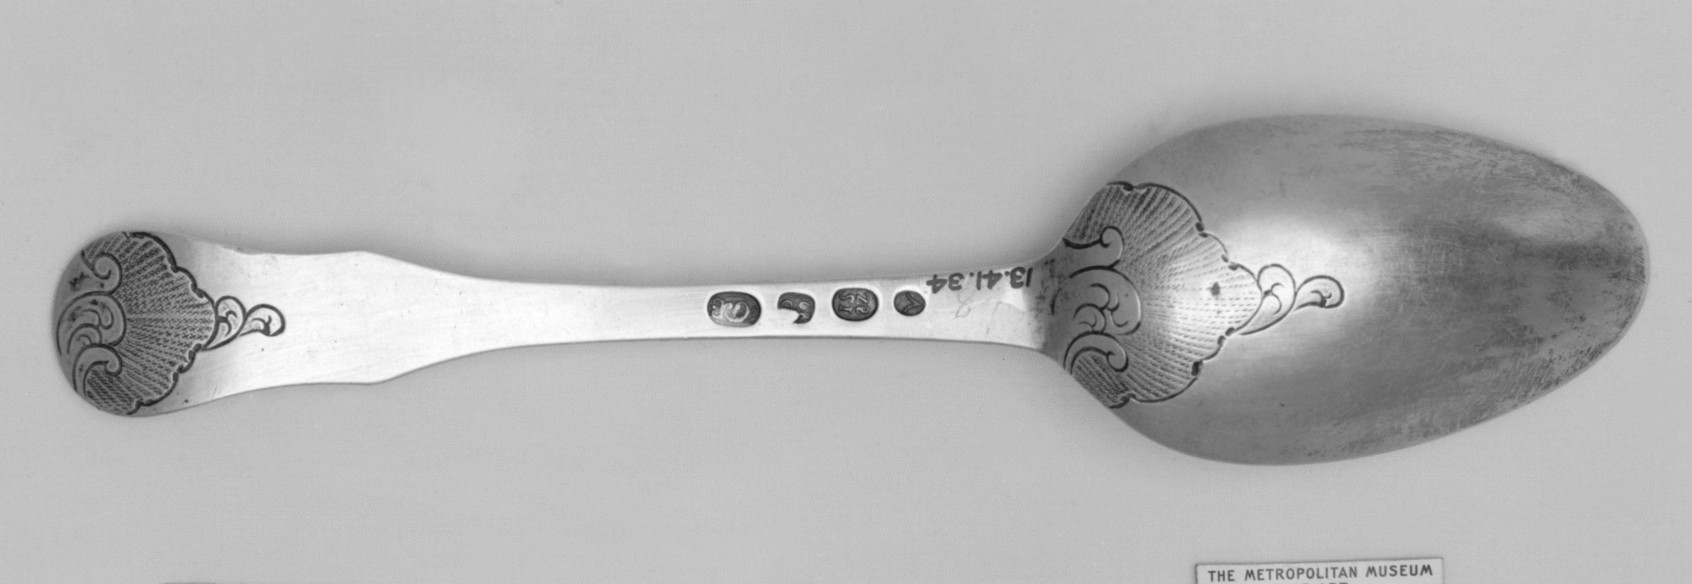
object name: spoon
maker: jacob steen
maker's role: maker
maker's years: 1740-1804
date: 1789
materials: silver